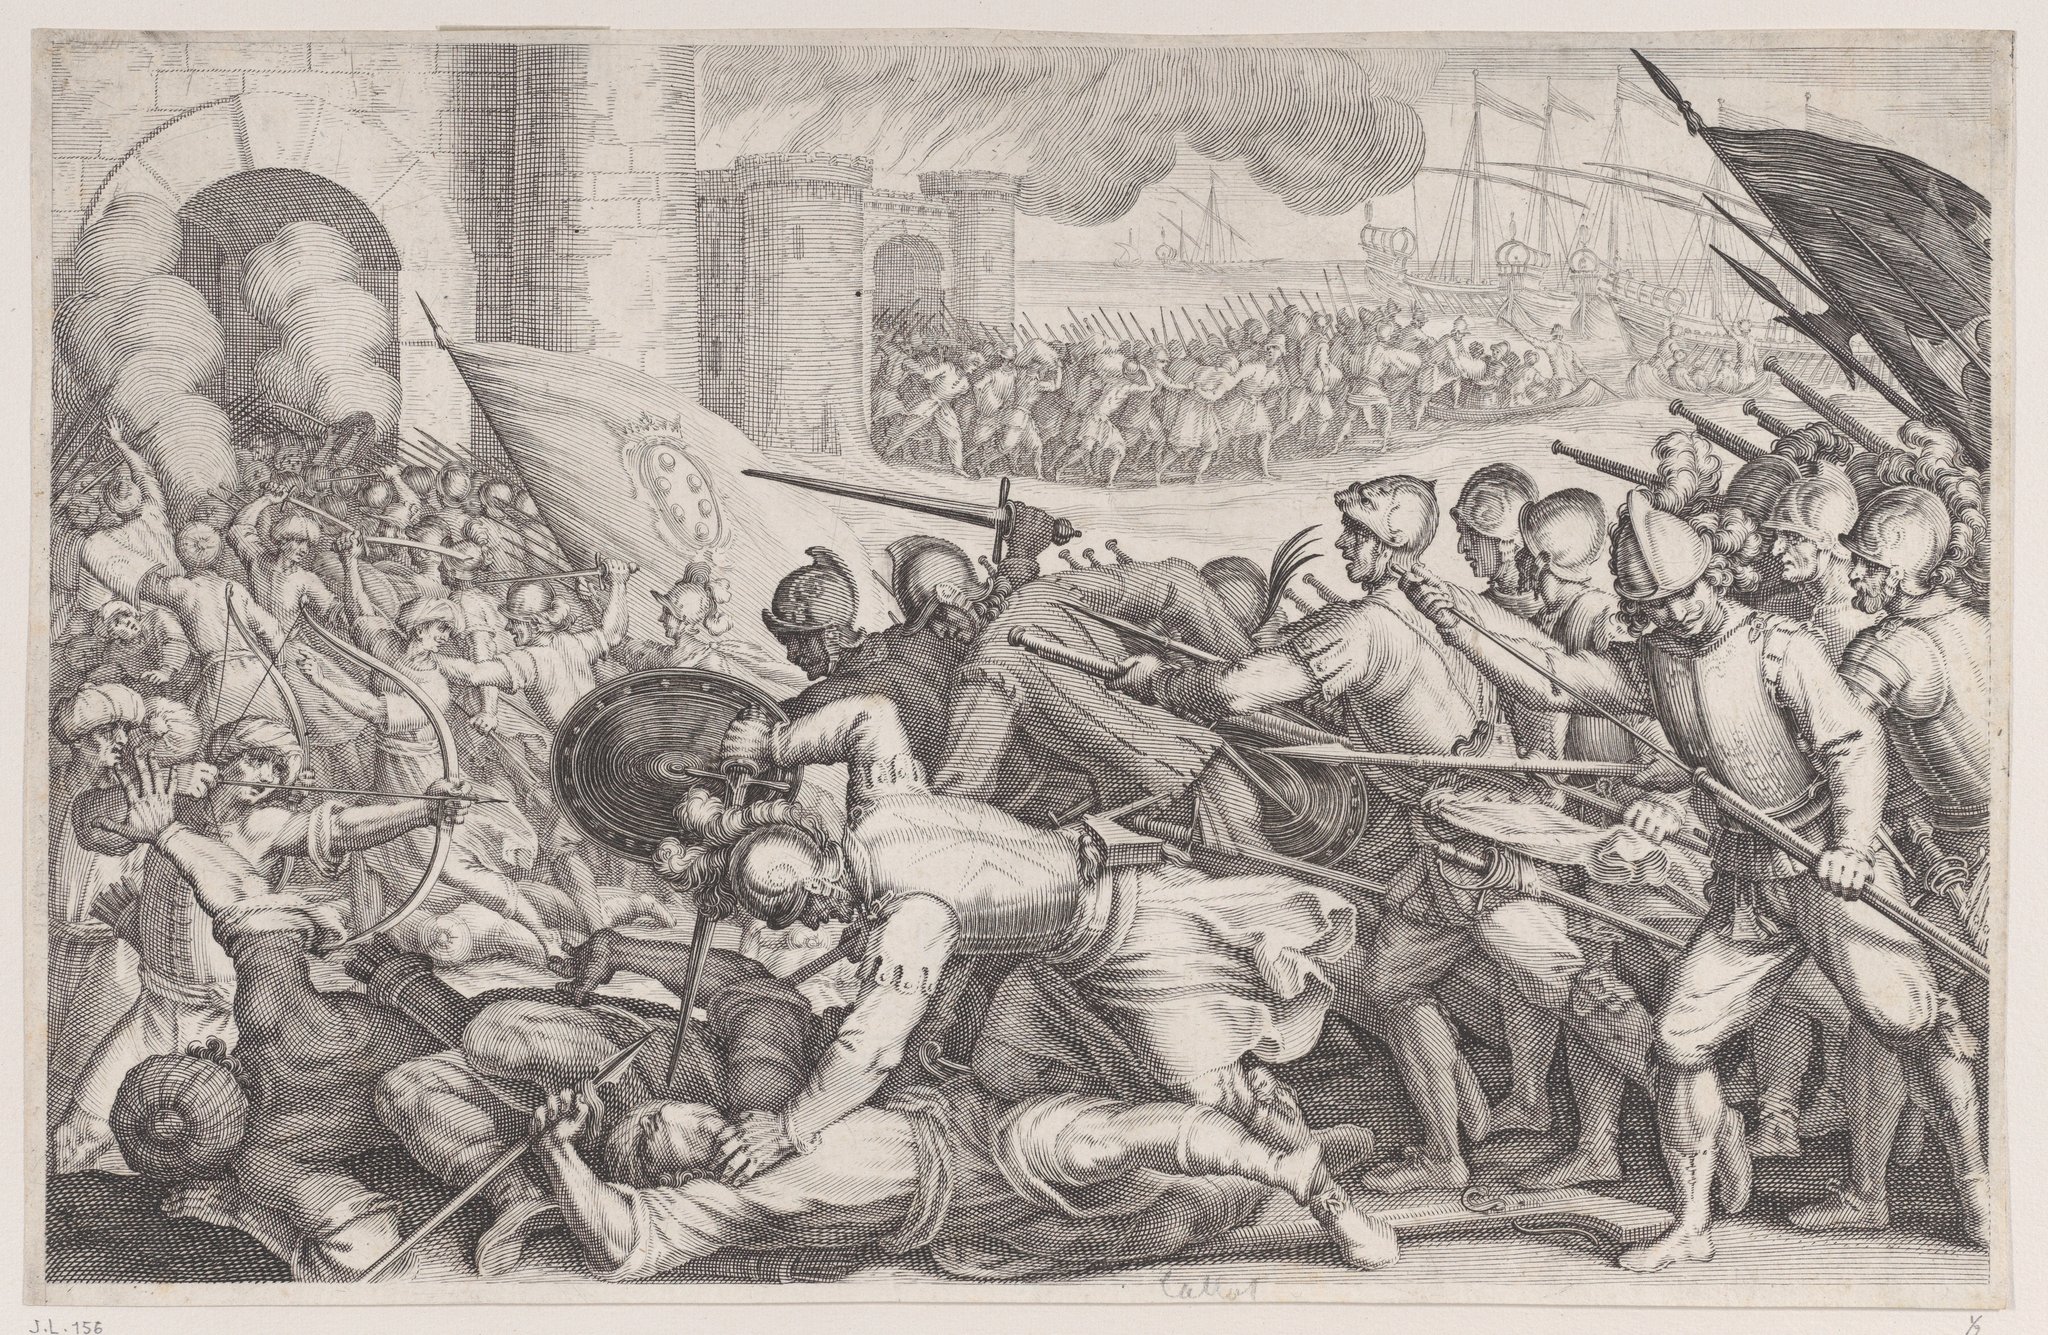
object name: print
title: Les Troupes Forcent la Porte d'une Ville (The Troops Force Their Way Through the Gate of a City), from "La Vie de Ferdinand Ier de Médicis série appelée aussi Les Batailles des Médicis" (The Life of Ferdinand I de'Medici also called The Medici Battles)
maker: jacques callot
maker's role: artist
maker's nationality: french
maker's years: 1592-1635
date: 1614-1620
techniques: engraving